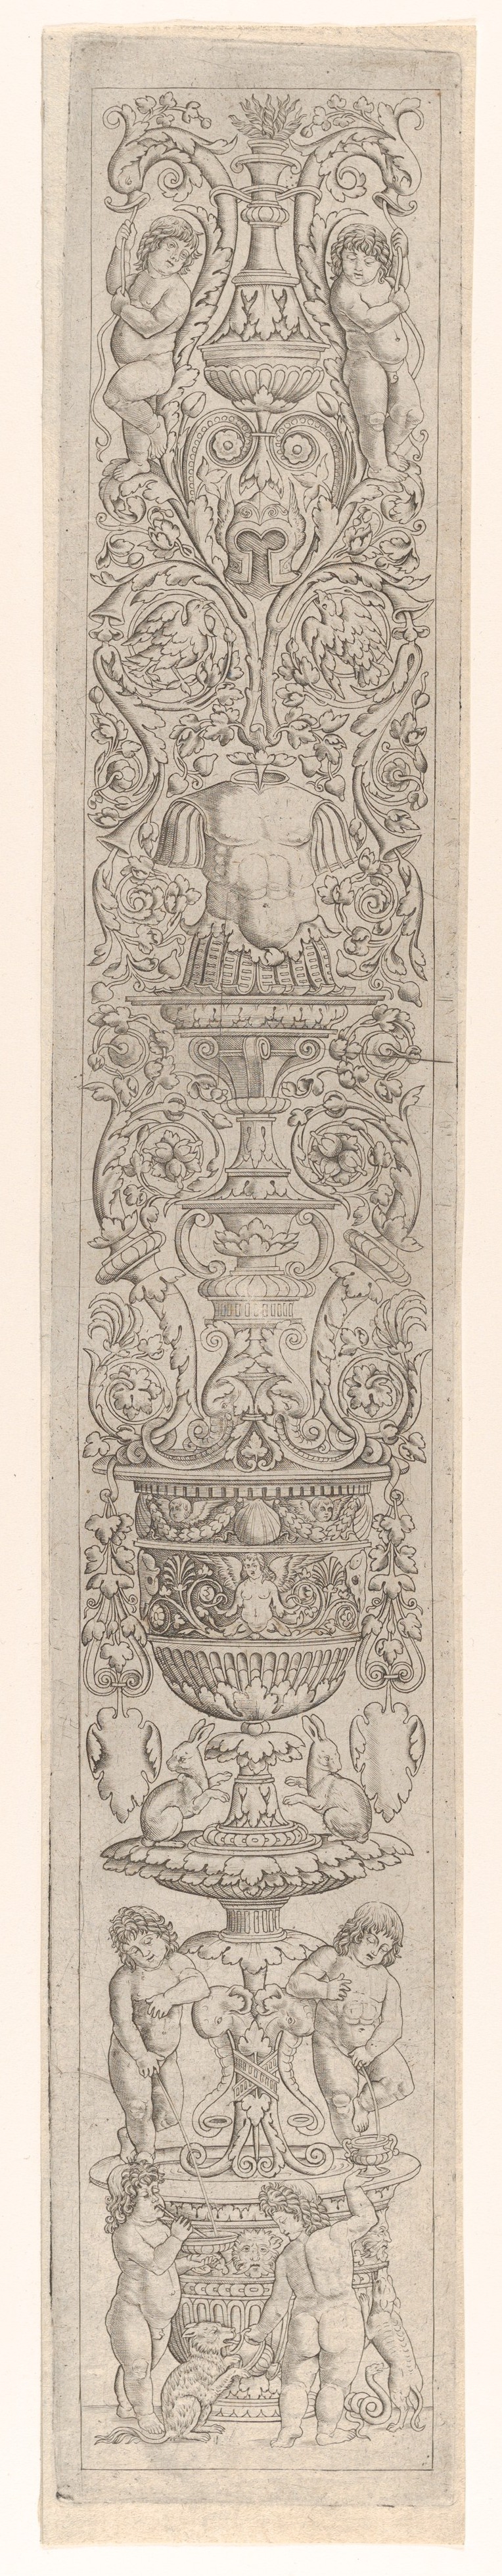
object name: print ornament architecture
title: Candelabra grotesque with four children with a cat and a dog, from a series of twelve candelabra grotesques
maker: giovanni antonio da brescia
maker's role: artist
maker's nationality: italian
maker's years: 1490-1525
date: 1490-1515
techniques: engraving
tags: grotesques,children,cats,dogs,candelabra